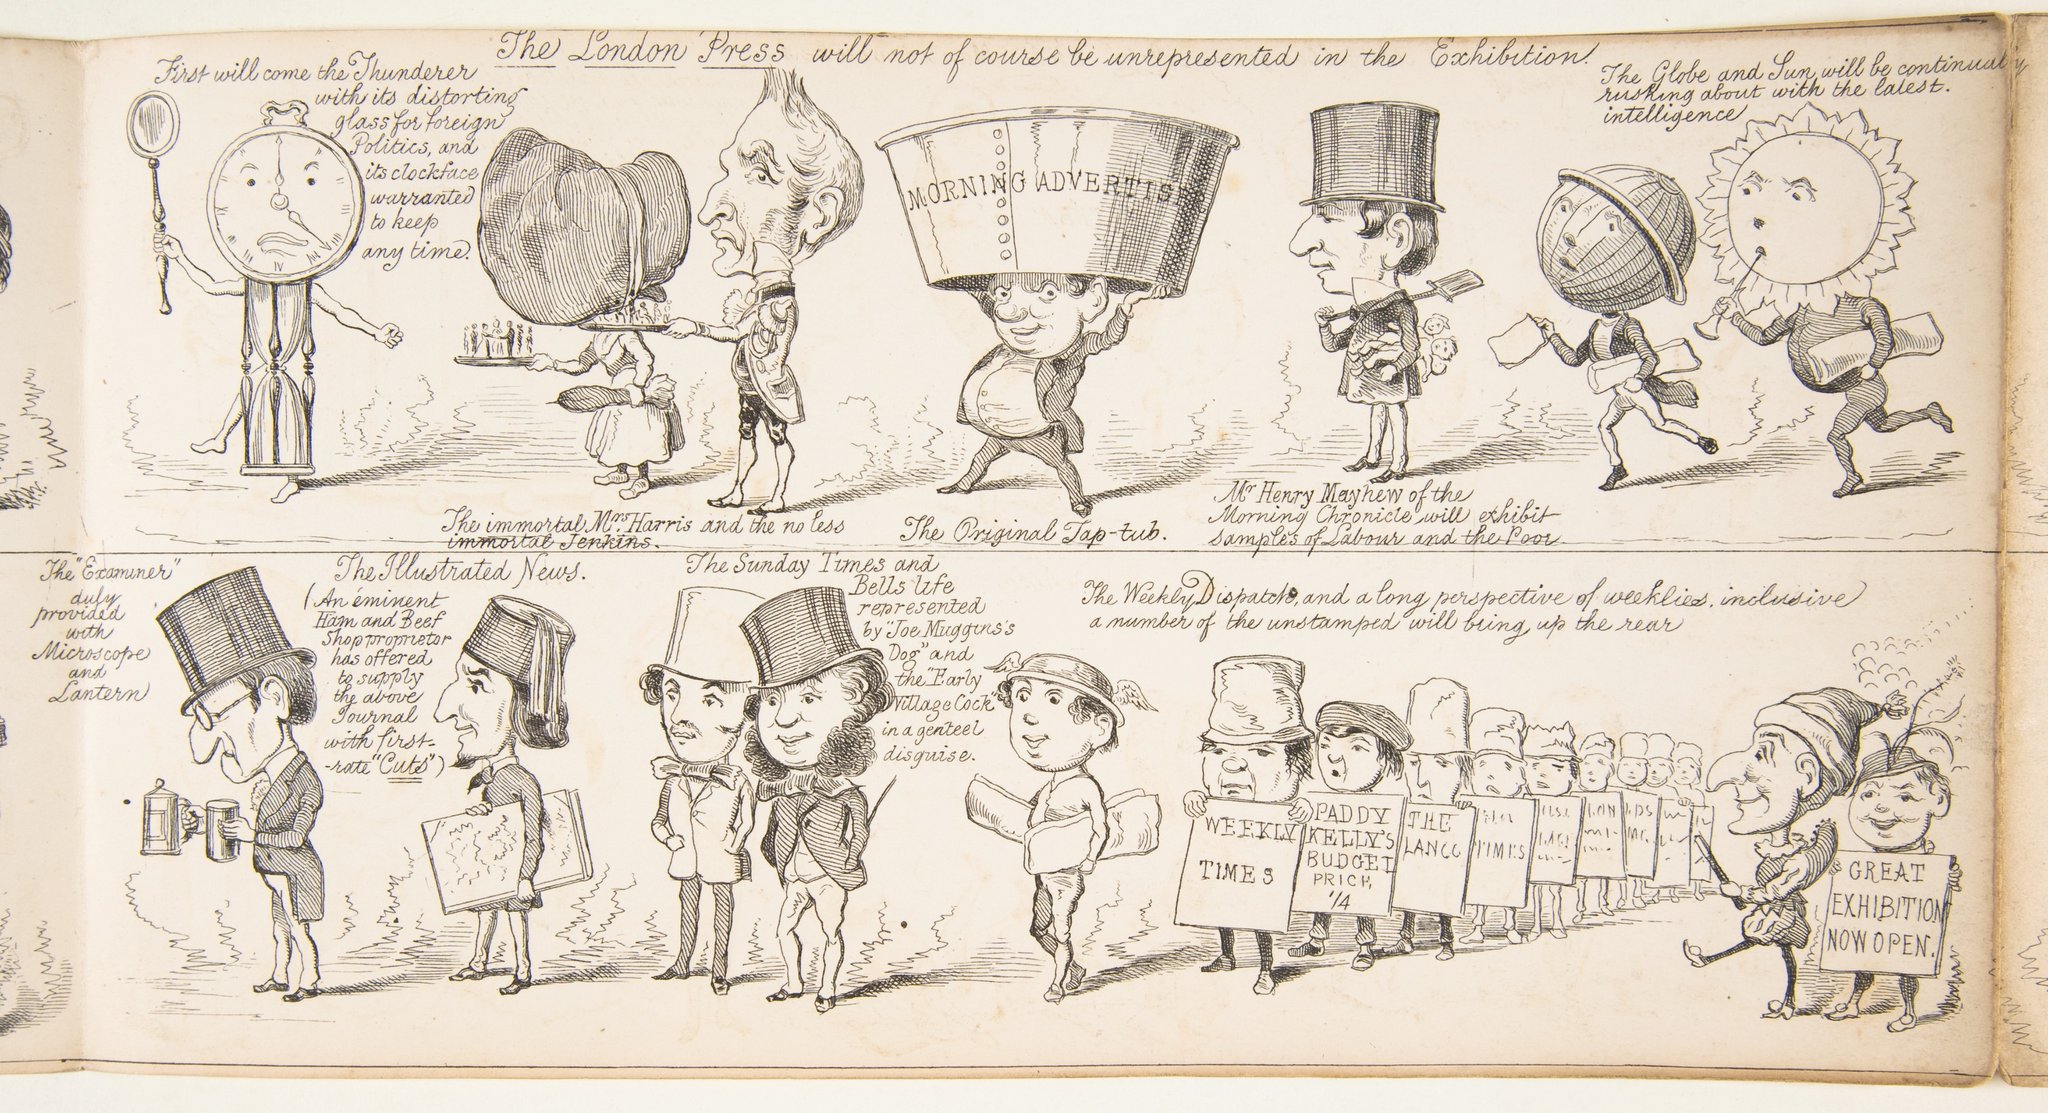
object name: print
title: The Great Exhibition "Wot is to Be", Probable Results of The Industry of All Nations in The Year '51, Showing What is to be Exhibited, Who is To Exhibit, in Short How Its All Going to Be Done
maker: george augustus sala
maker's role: author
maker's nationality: british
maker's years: 1828-1895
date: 1850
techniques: engraving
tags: satire,men,clocks